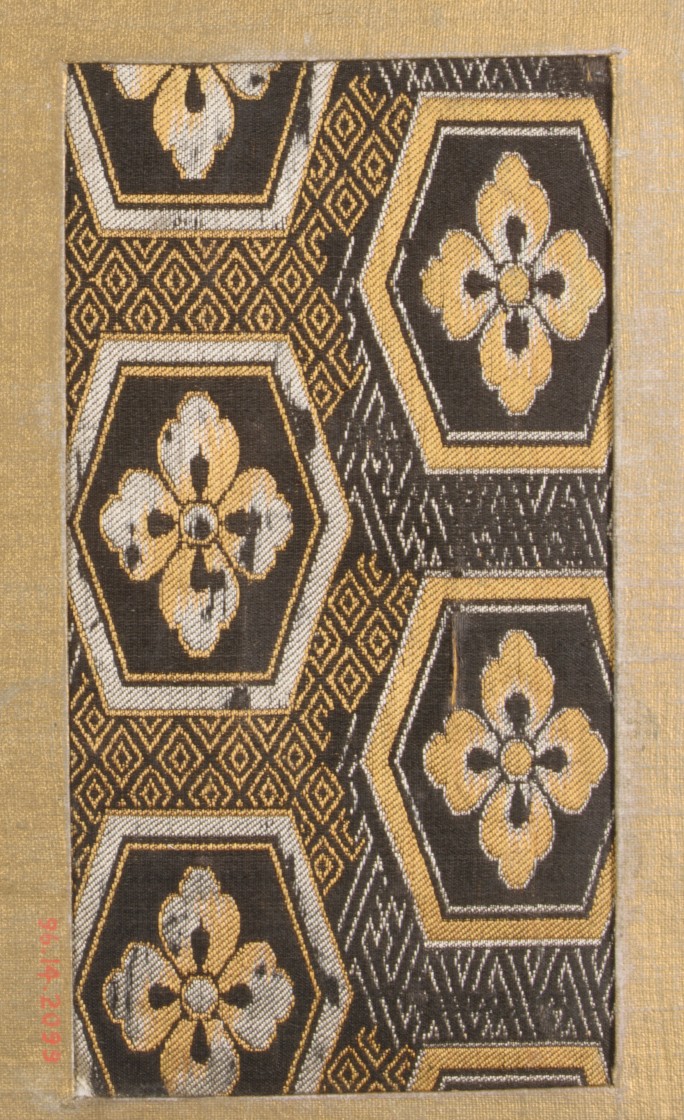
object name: piece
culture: japanese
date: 1701-1900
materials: silk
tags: flowers